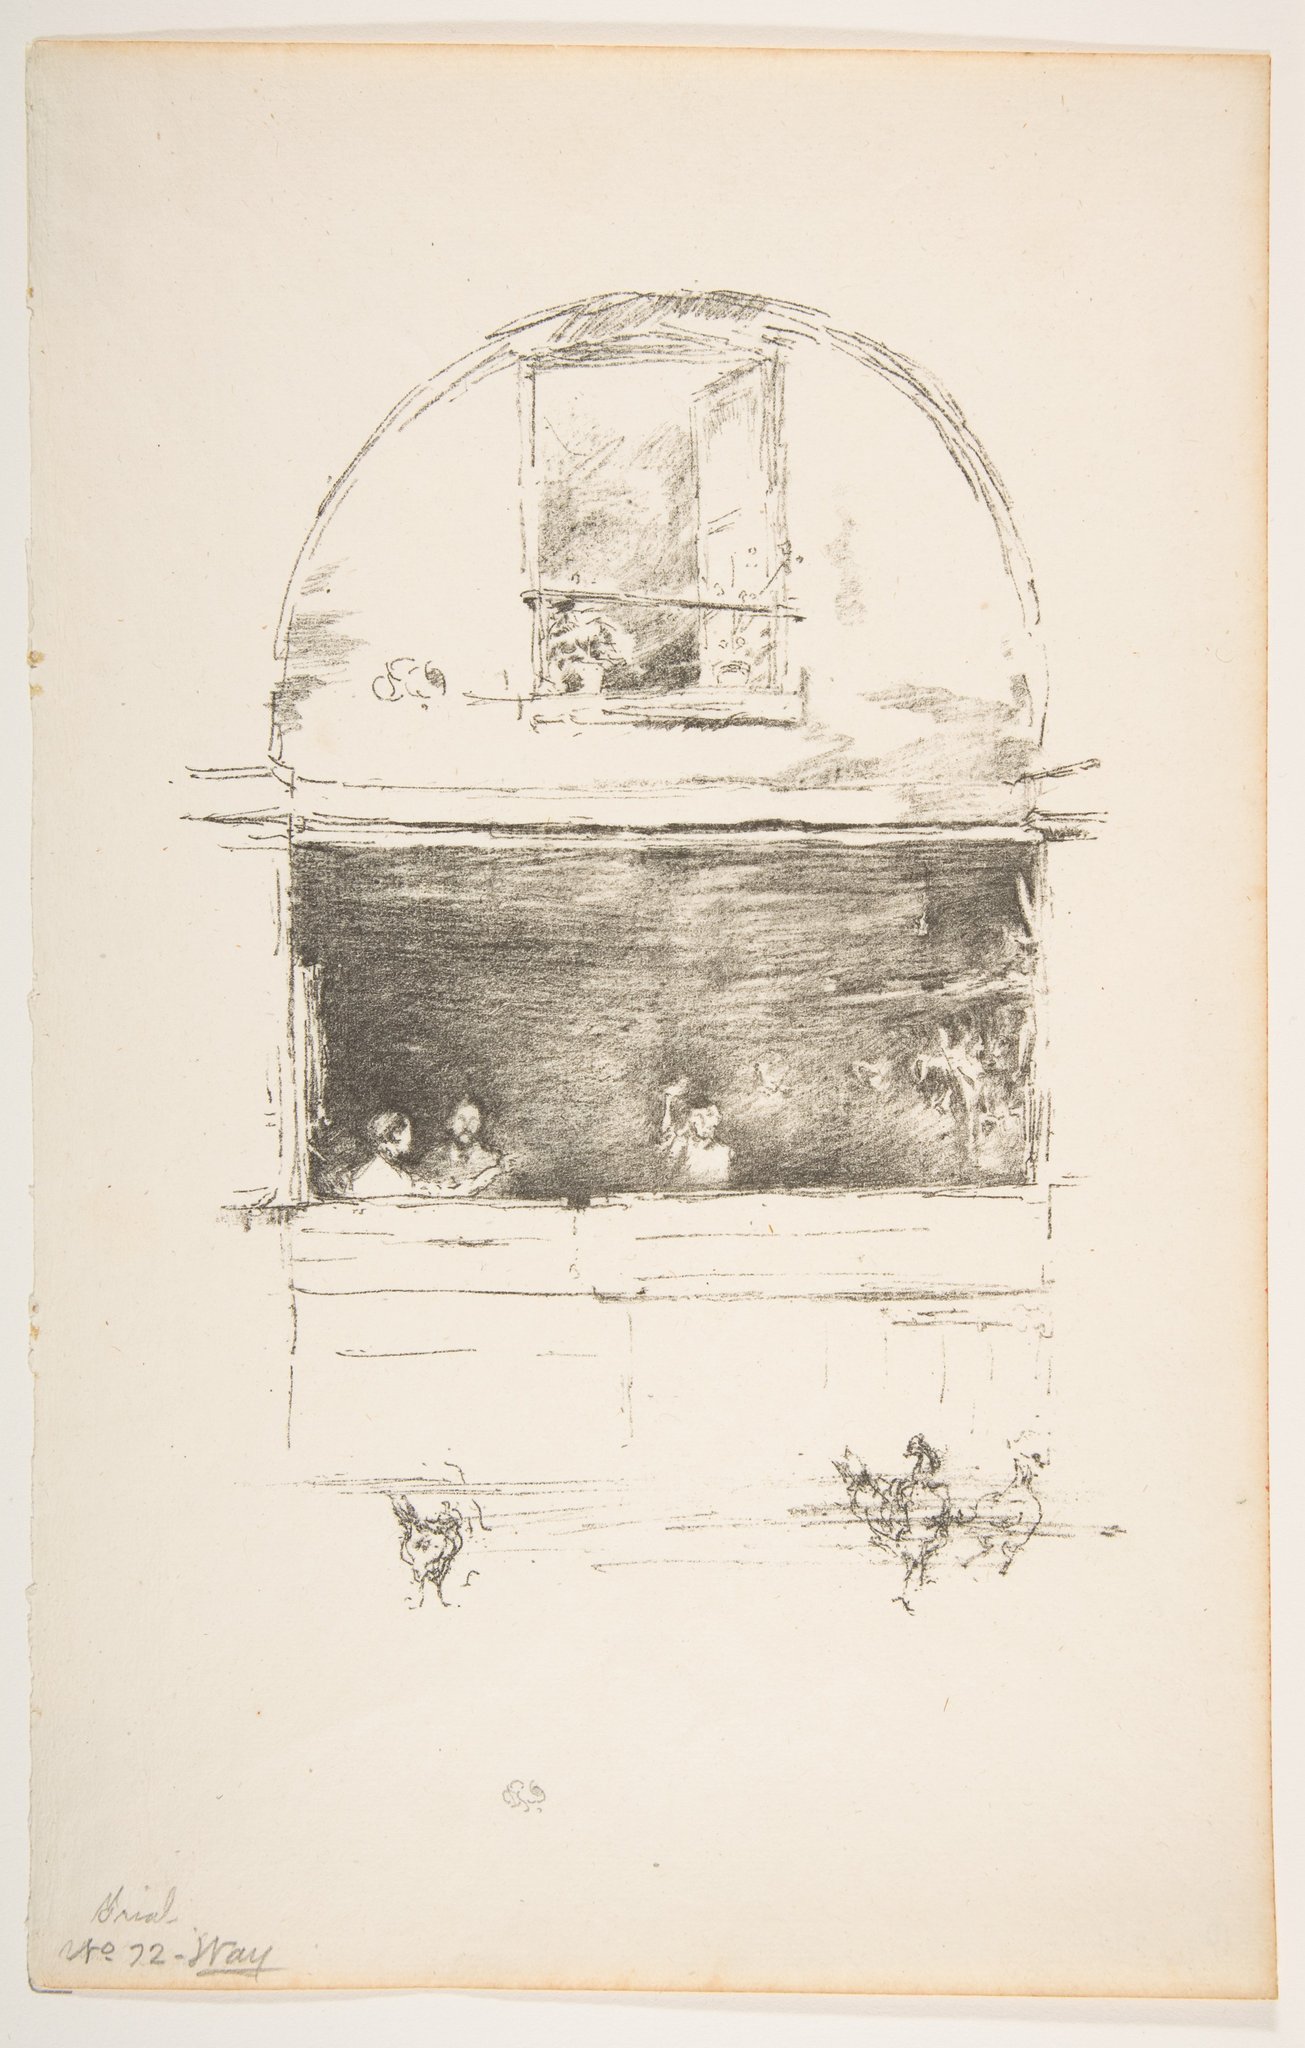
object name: print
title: The Forge–Passage du Dragon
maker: james mcneill whistler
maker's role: artist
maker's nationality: american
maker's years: 1834-1903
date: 1894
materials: ink, paper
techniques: printing, stumping, lithography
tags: windows